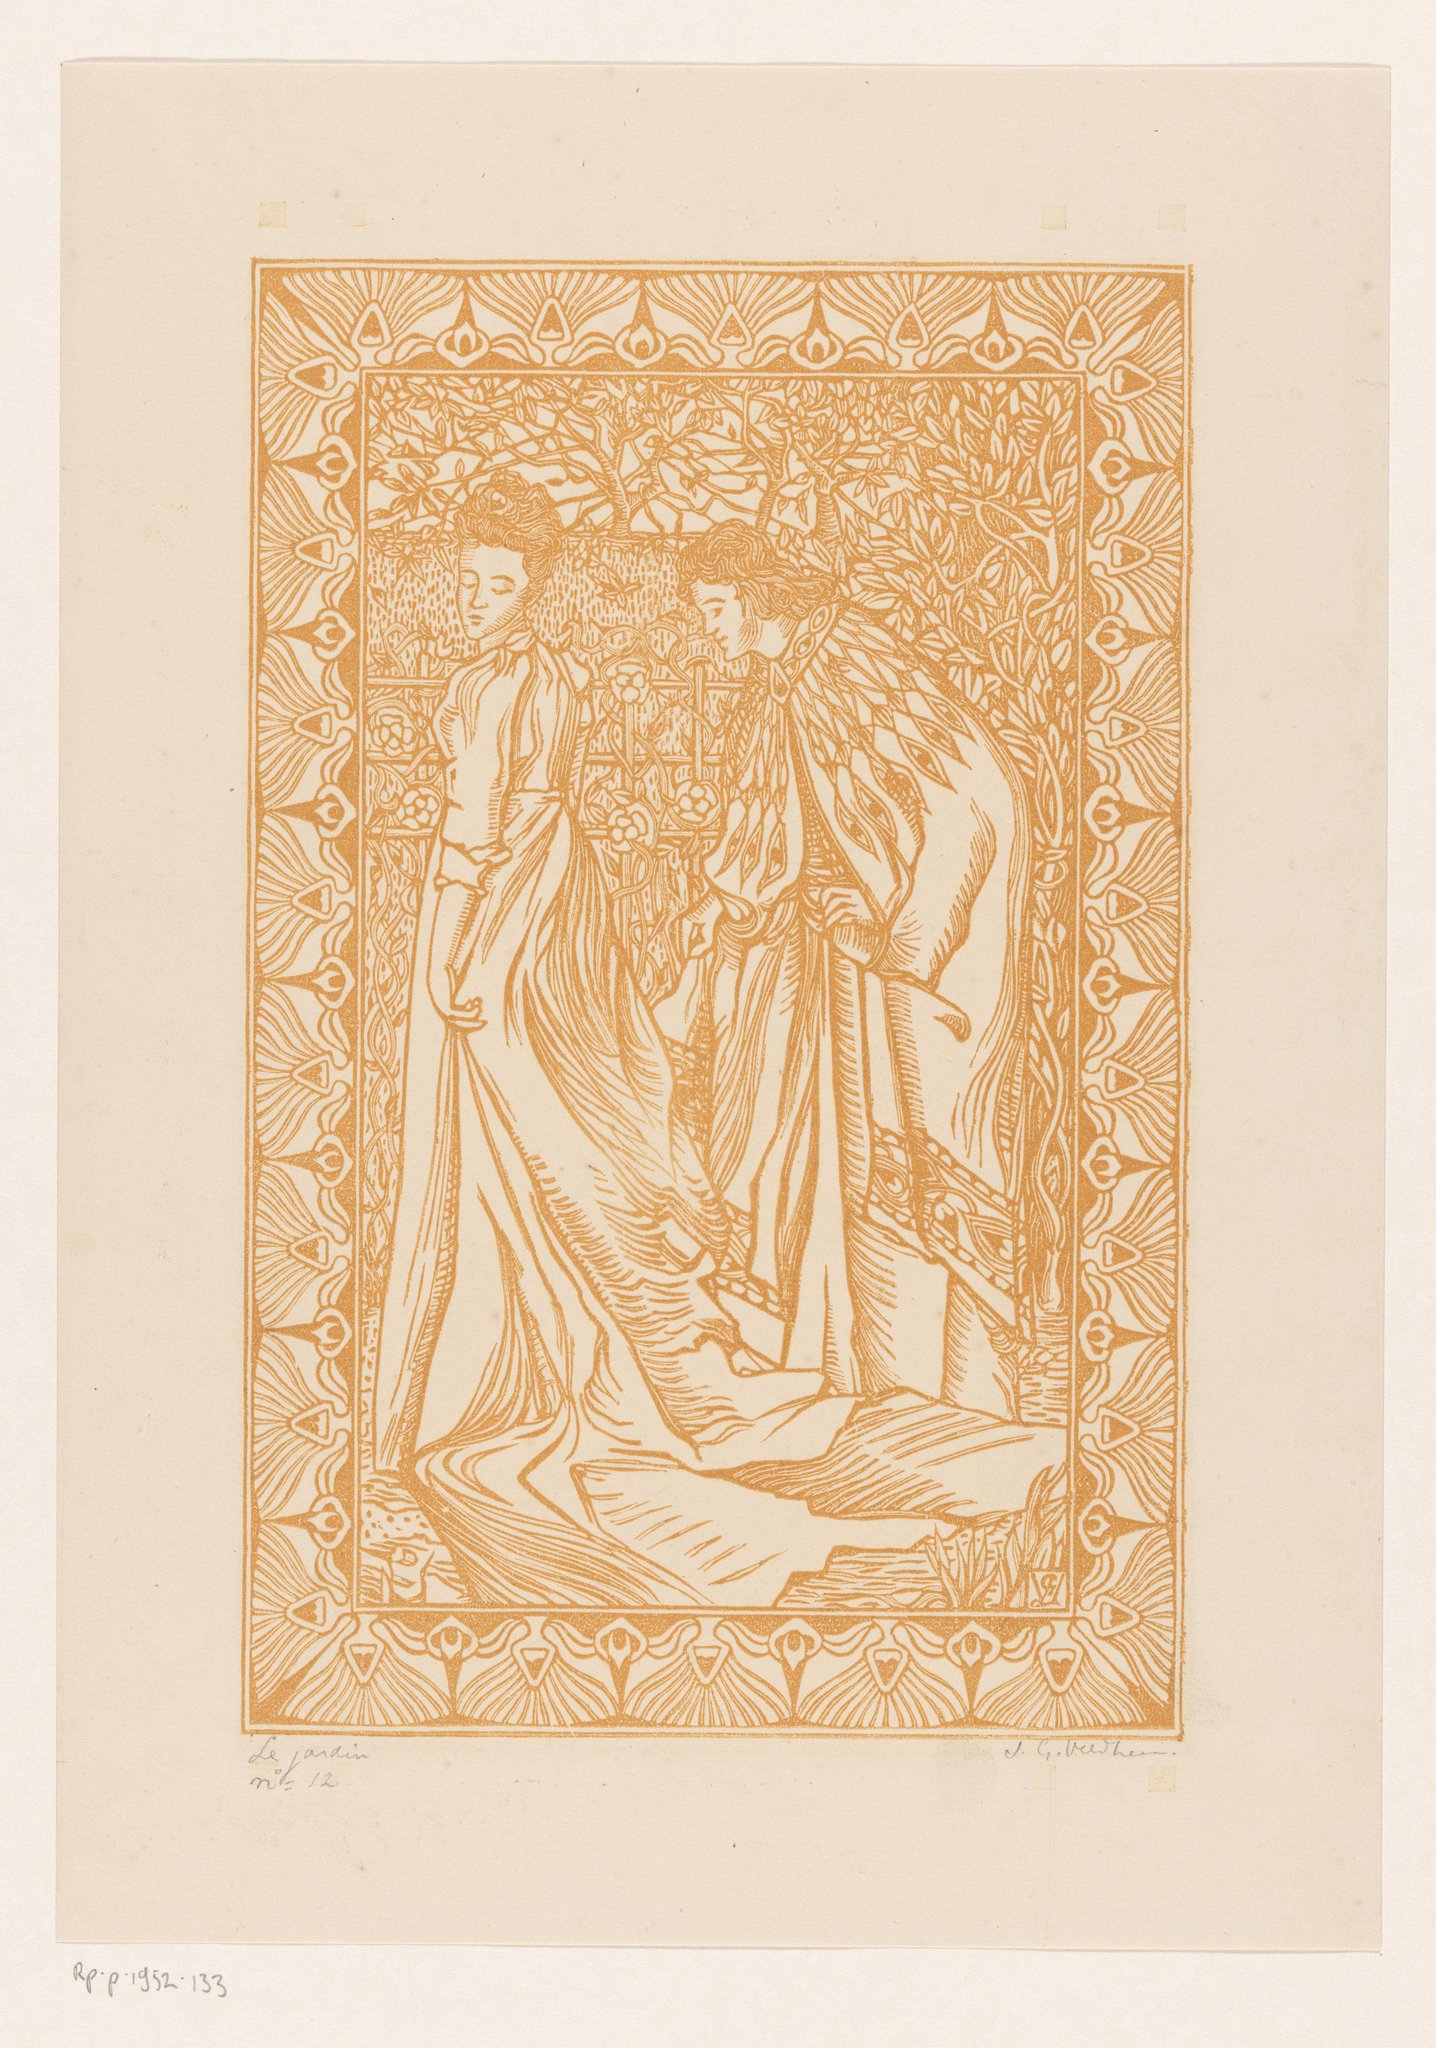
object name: print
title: Le Jardin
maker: jacobus gerardus veldheer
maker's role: draughtsman, print maker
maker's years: 1866-1954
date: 1876-1952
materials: paper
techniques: woodcut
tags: garden, courting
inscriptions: collector's mark: Lugt 2228